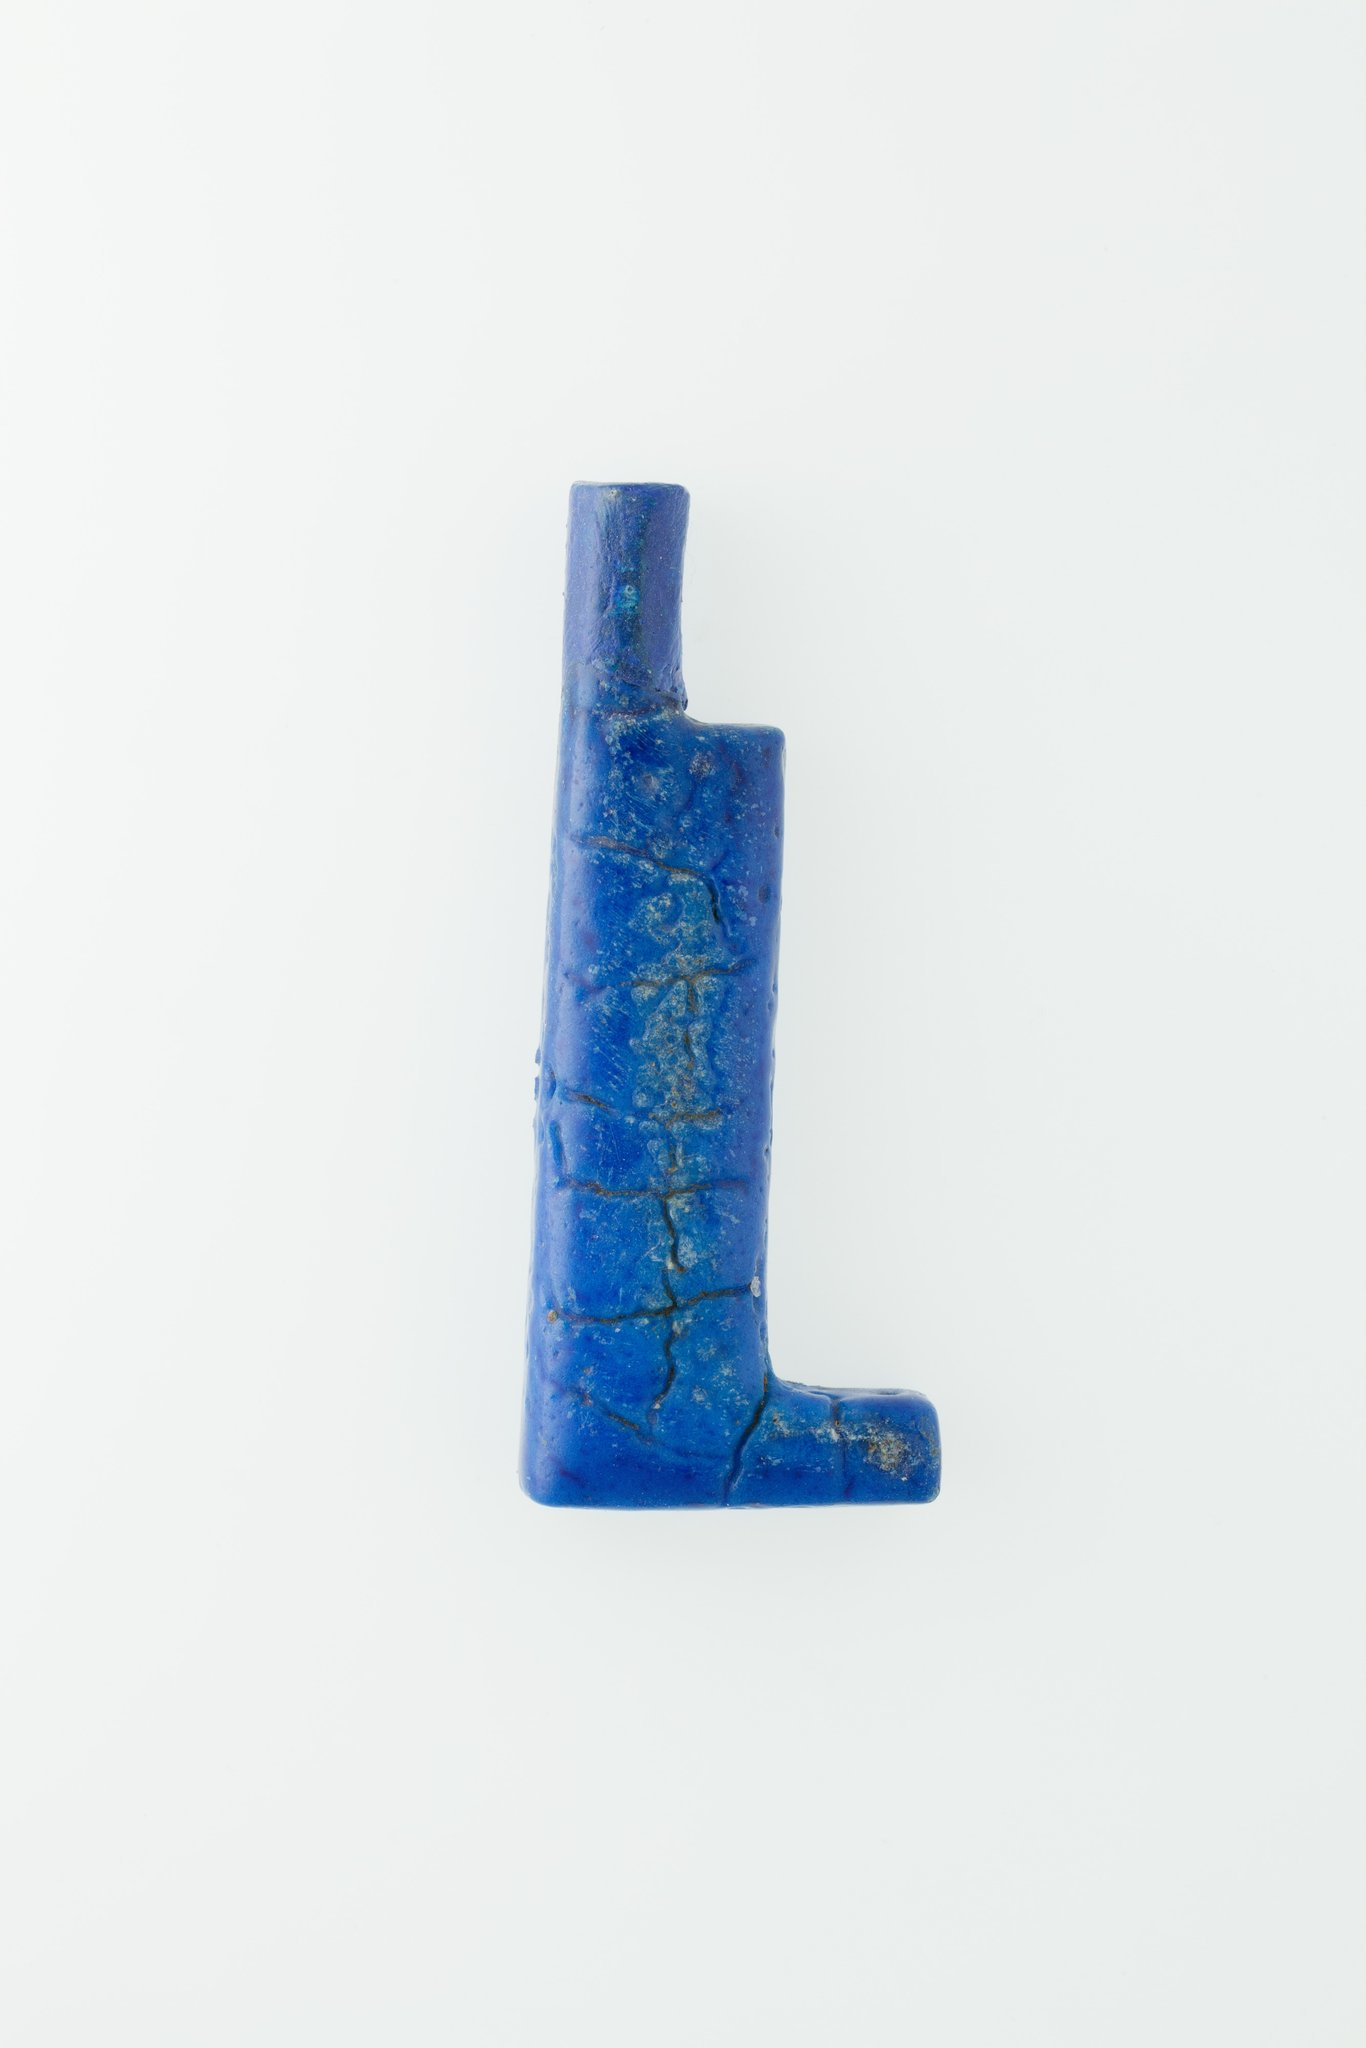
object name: inlay, hieroglyph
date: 664-610 BCE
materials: faience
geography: egypt